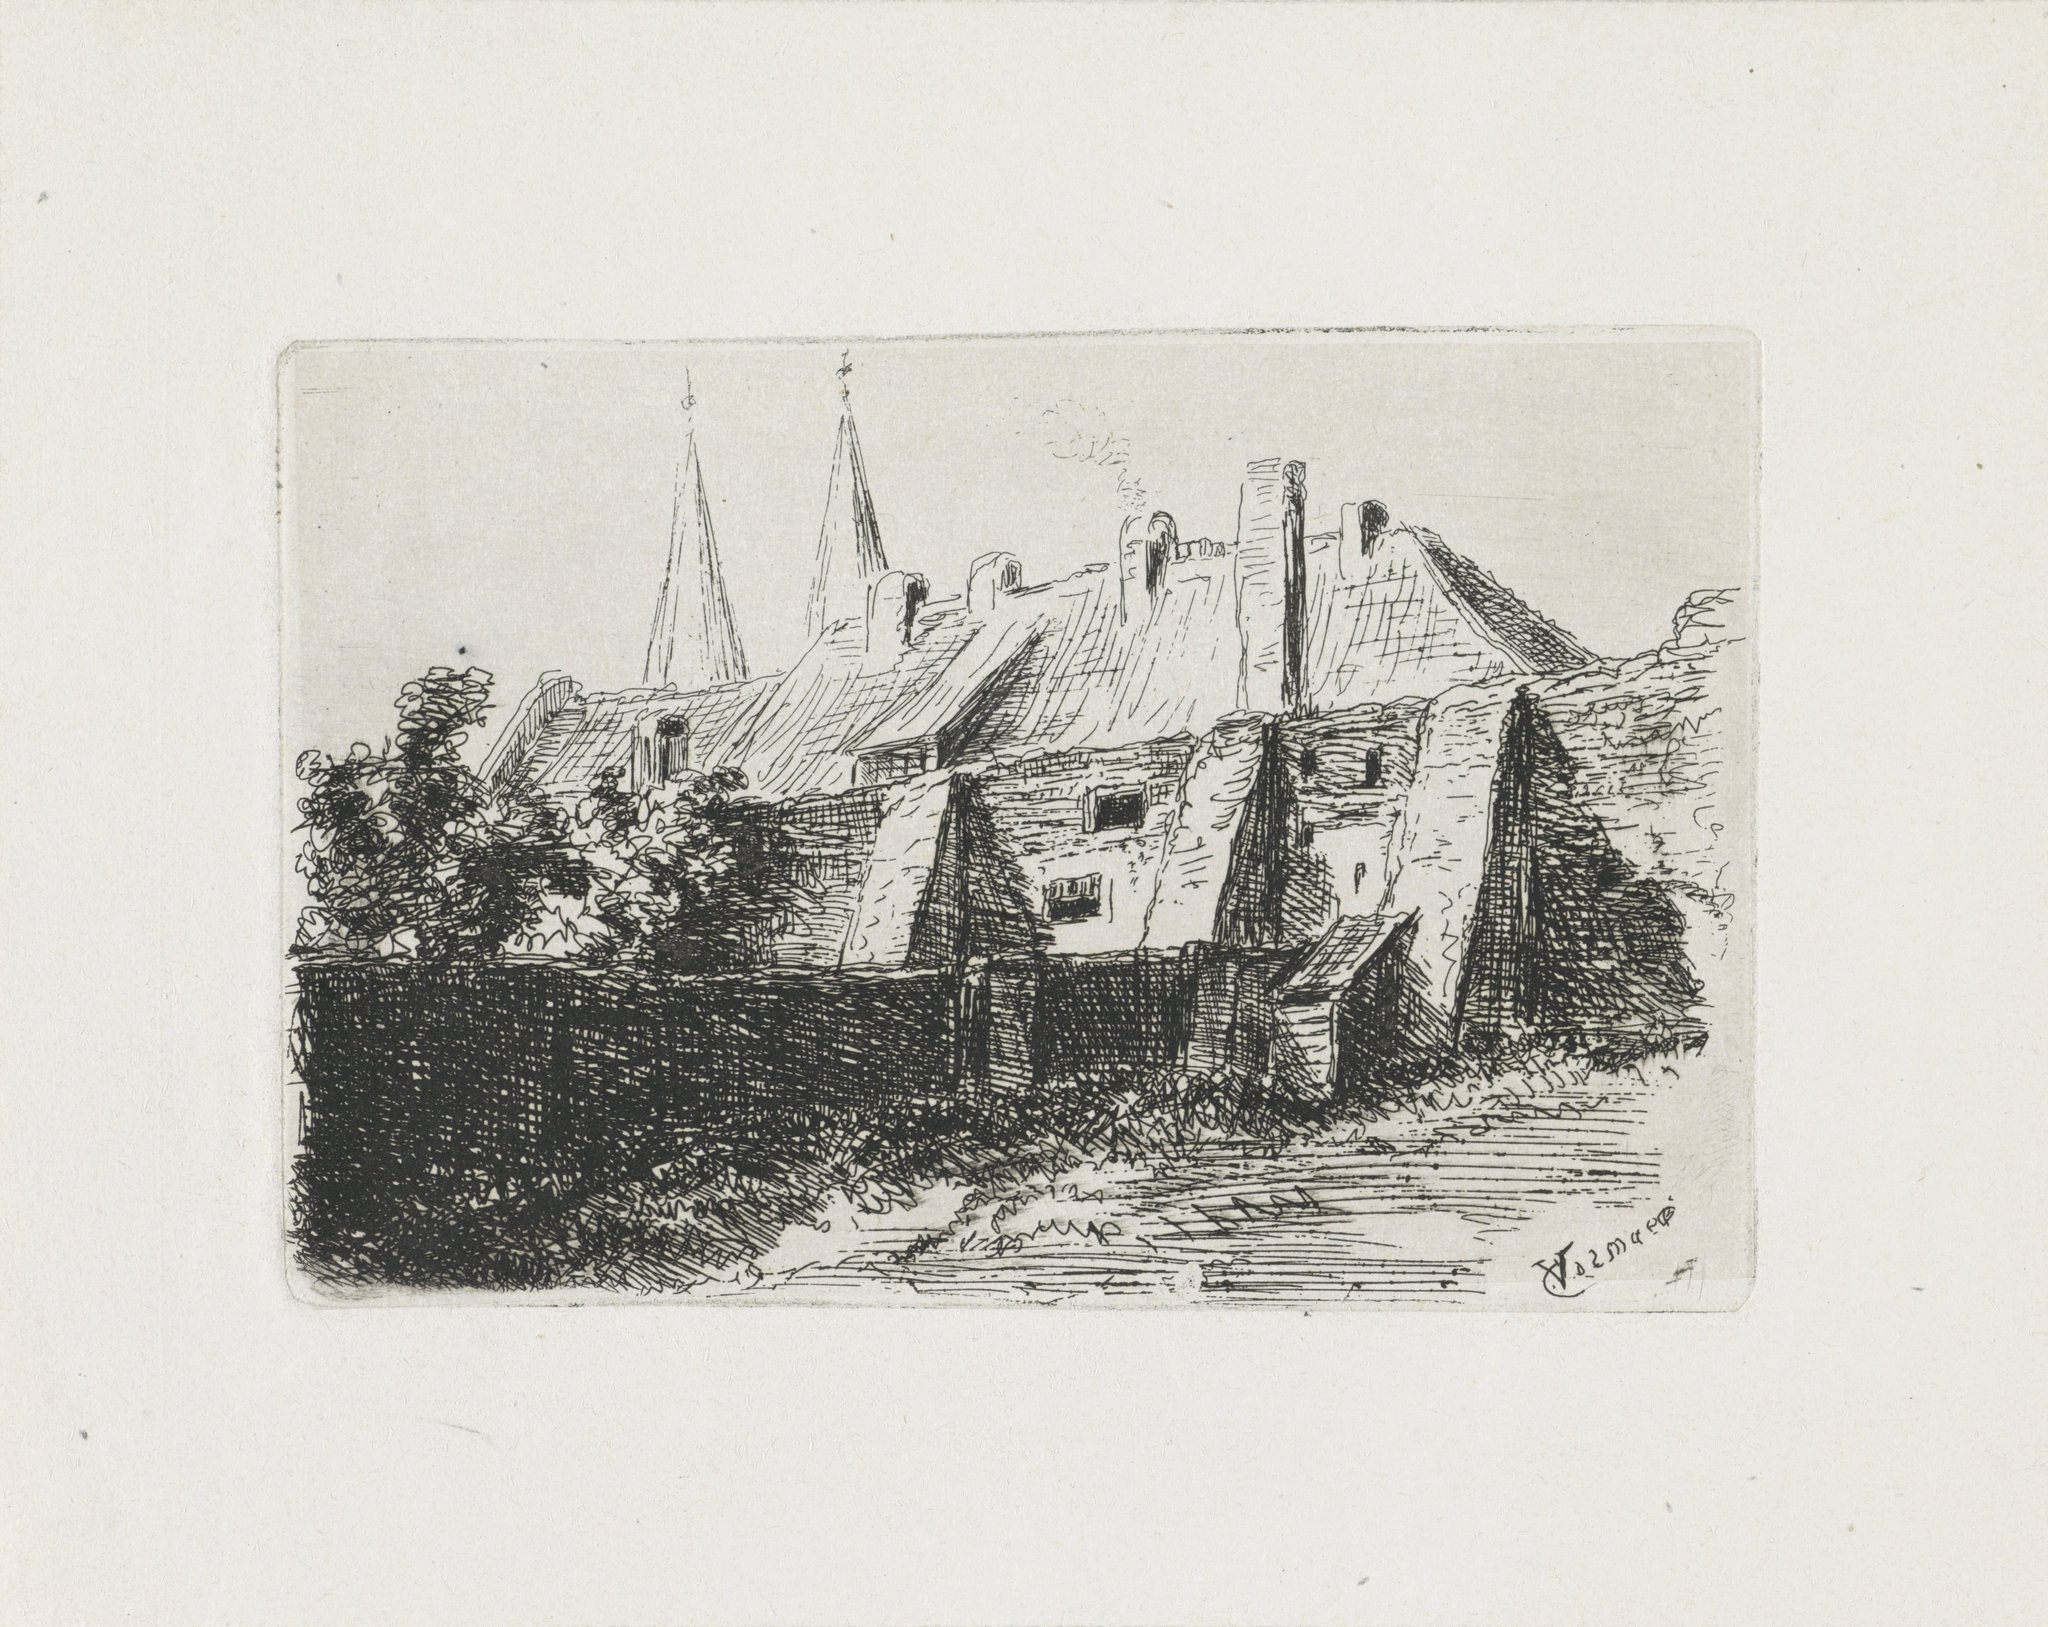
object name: print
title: Drie hoge bomen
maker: cornelis steffelaar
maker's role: draughtsman, painter, print maker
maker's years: 1797-1861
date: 1807-1861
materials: paper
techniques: etching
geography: amsterdam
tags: trees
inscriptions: collector's mark: Lugt 2228